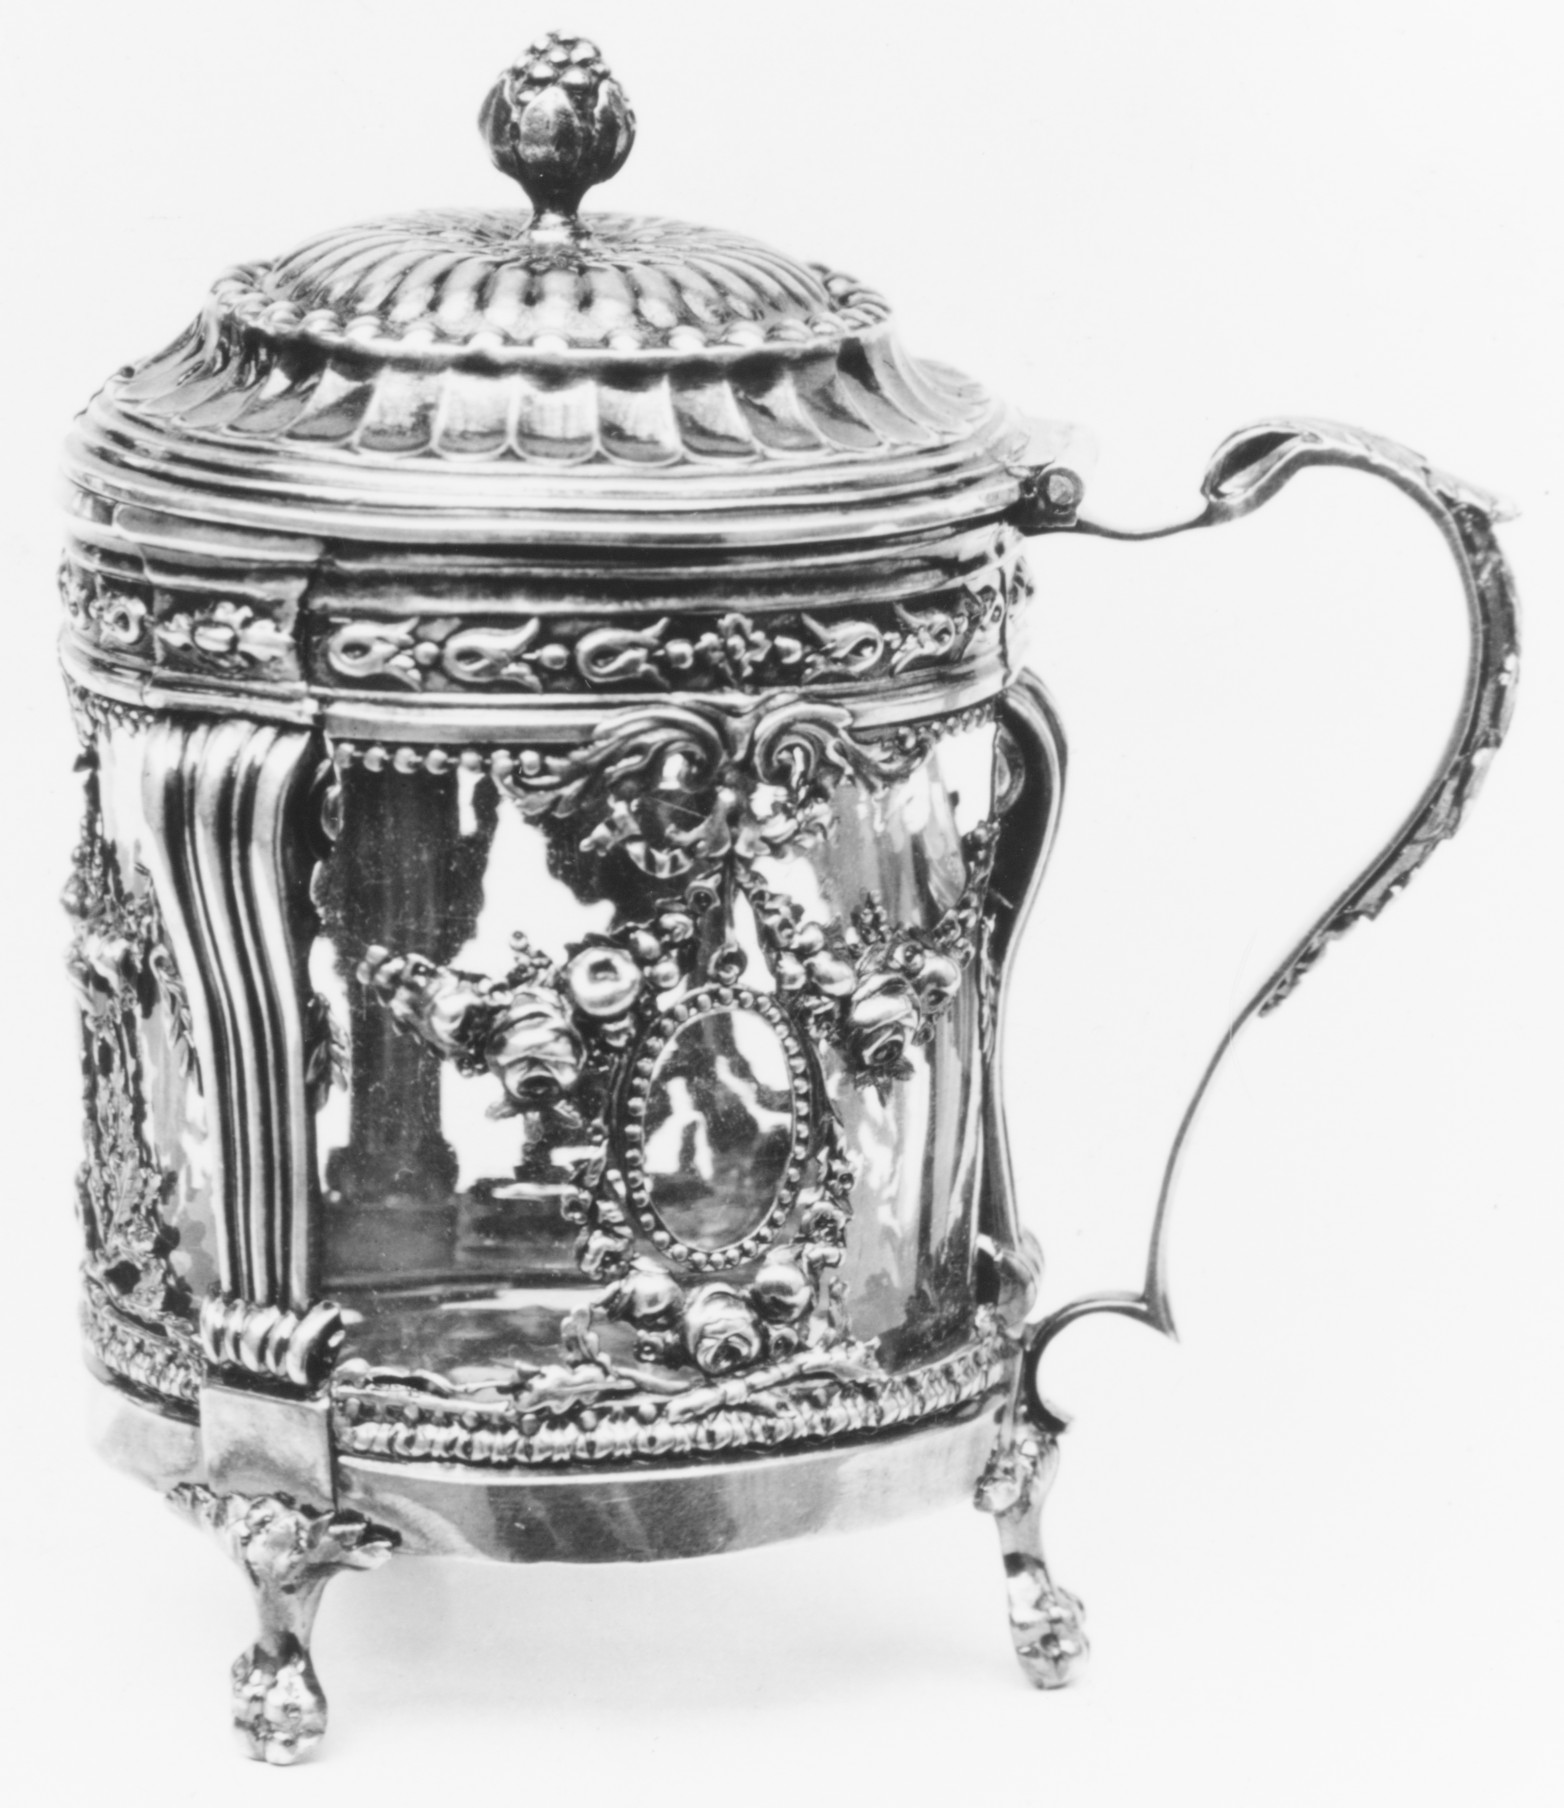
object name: mustard pot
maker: pierre-françois coste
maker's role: maker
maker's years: 1752-1823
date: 1786-1787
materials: glass, silver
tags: roses